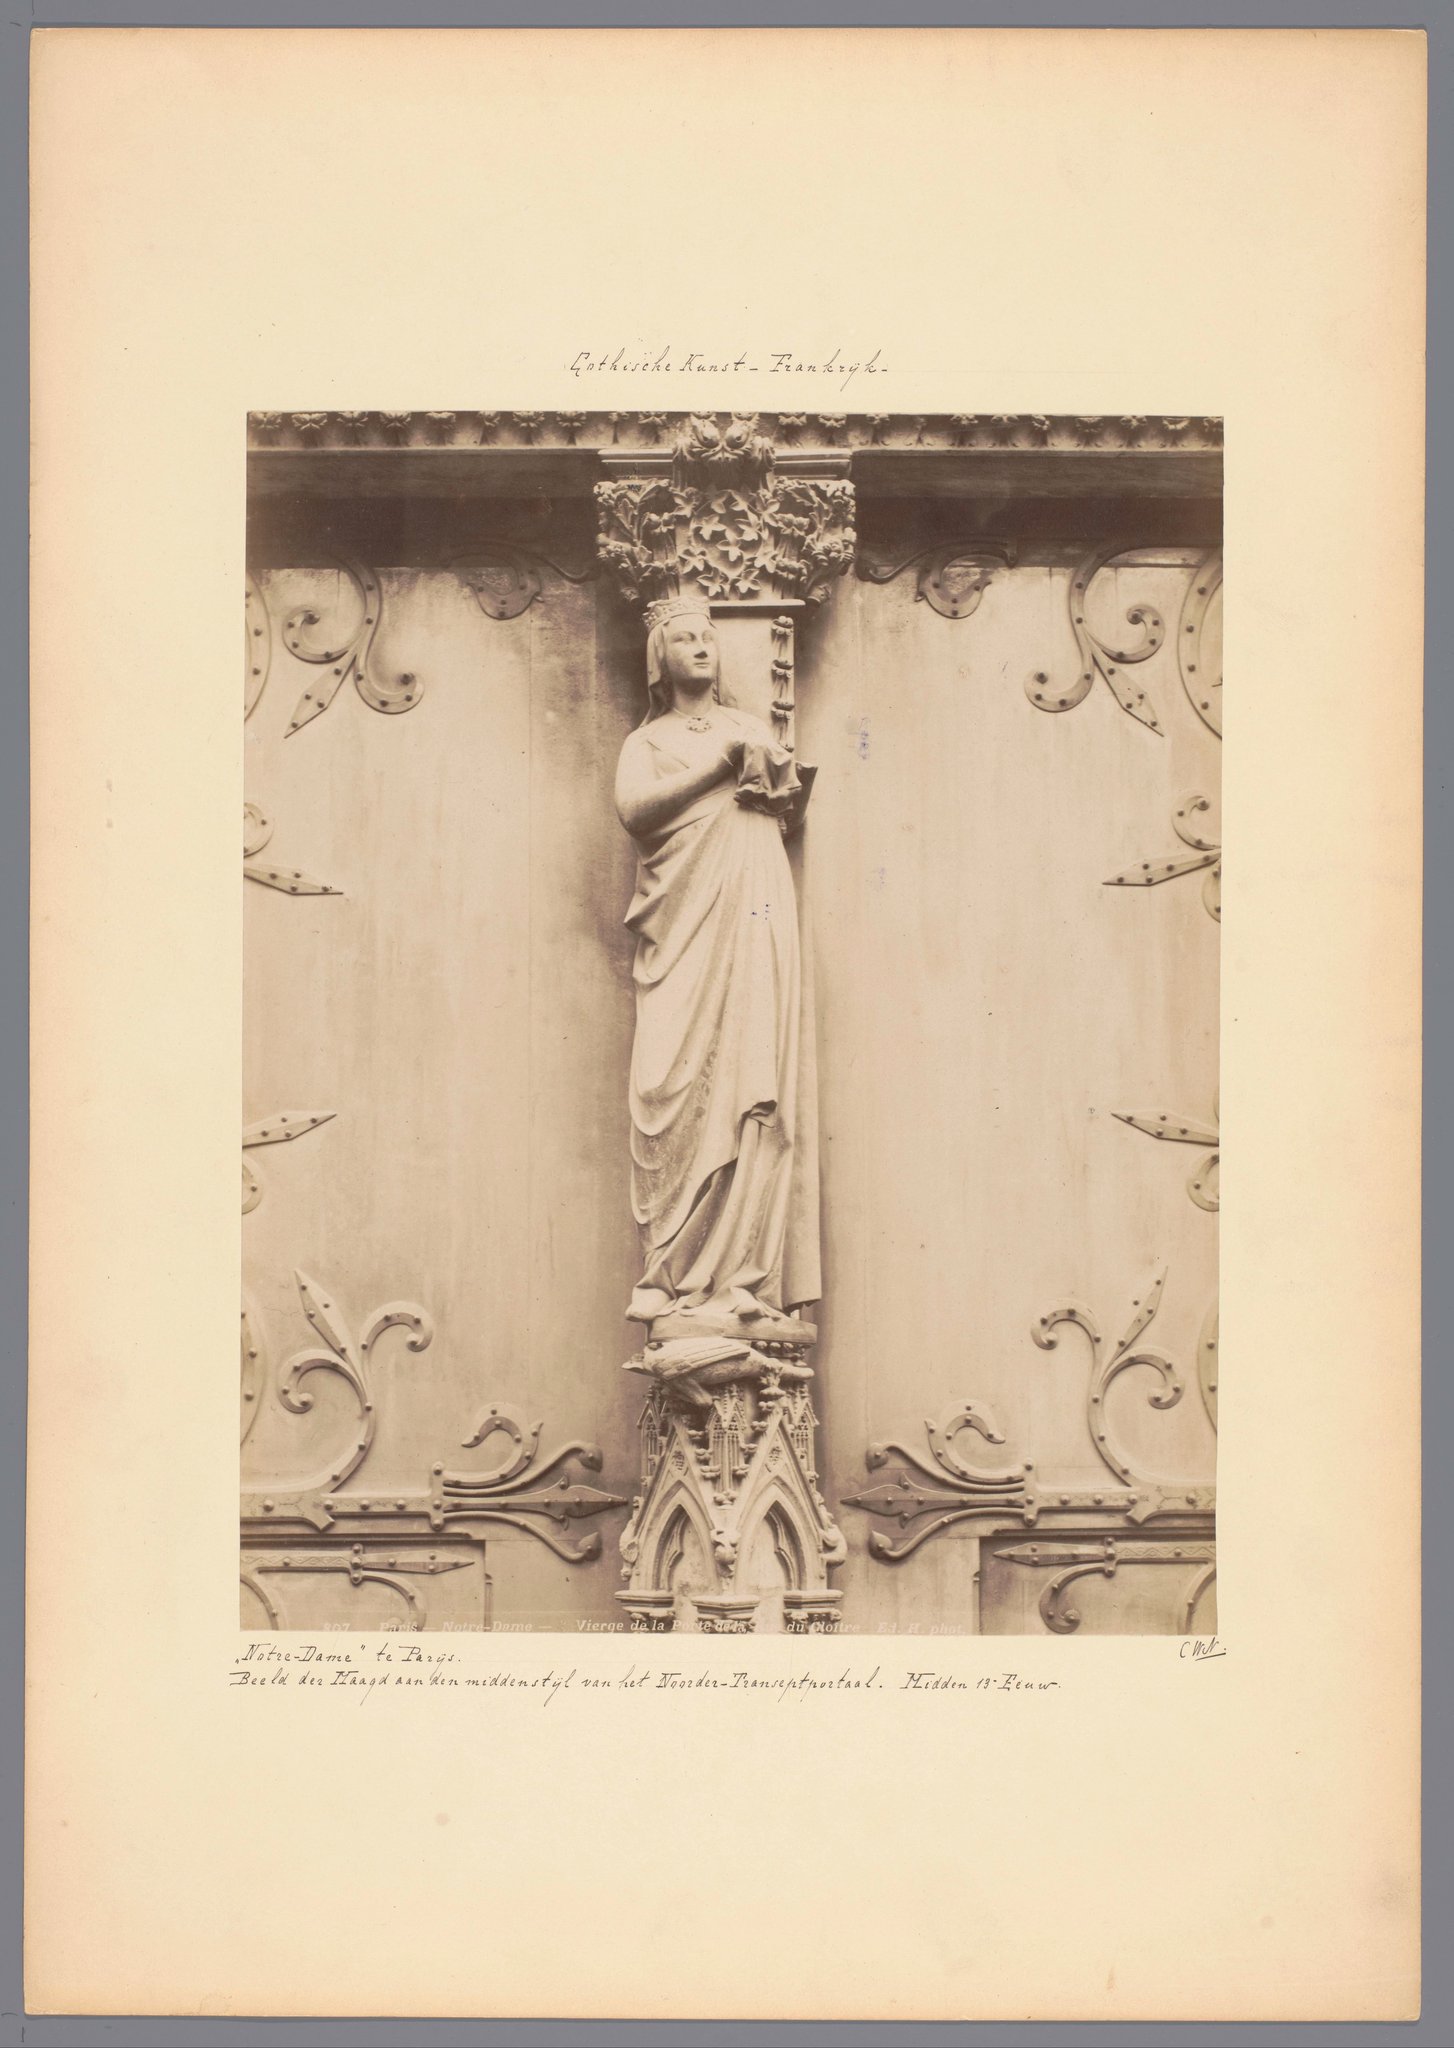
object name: photograph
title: Sculptuur van Maria aan het portaal van de Notre-Dame te Parijs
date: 1875-1900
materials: cardboard, photographic support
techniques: albumen print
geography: paris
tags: parts of church exterior and annexes: portal, mary (without the christ-child), sculpture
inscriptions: collector's mark: ‘KUNSTNIJVERHEIDSCHOOL QUELLINUS AMSTERDAM FRANS HALSSTRAAT 14.’, collector's mark: ‘INSTITUUT VOOR KUNST- NIJVERHEIDSONDERWIJS GABRIËL METSUSTRAAT No. 16. AMSTERDAM’, inscription: ‘CWN.’, name: ‘J. KUHN 220, Rue de Rivoli PARIS’, inscription: ‘Gothische Kunst - Frankrijk. ,,Notre-Dame'' te Parijs (...) Midden 13e Eeuw.’, number: ‘807’